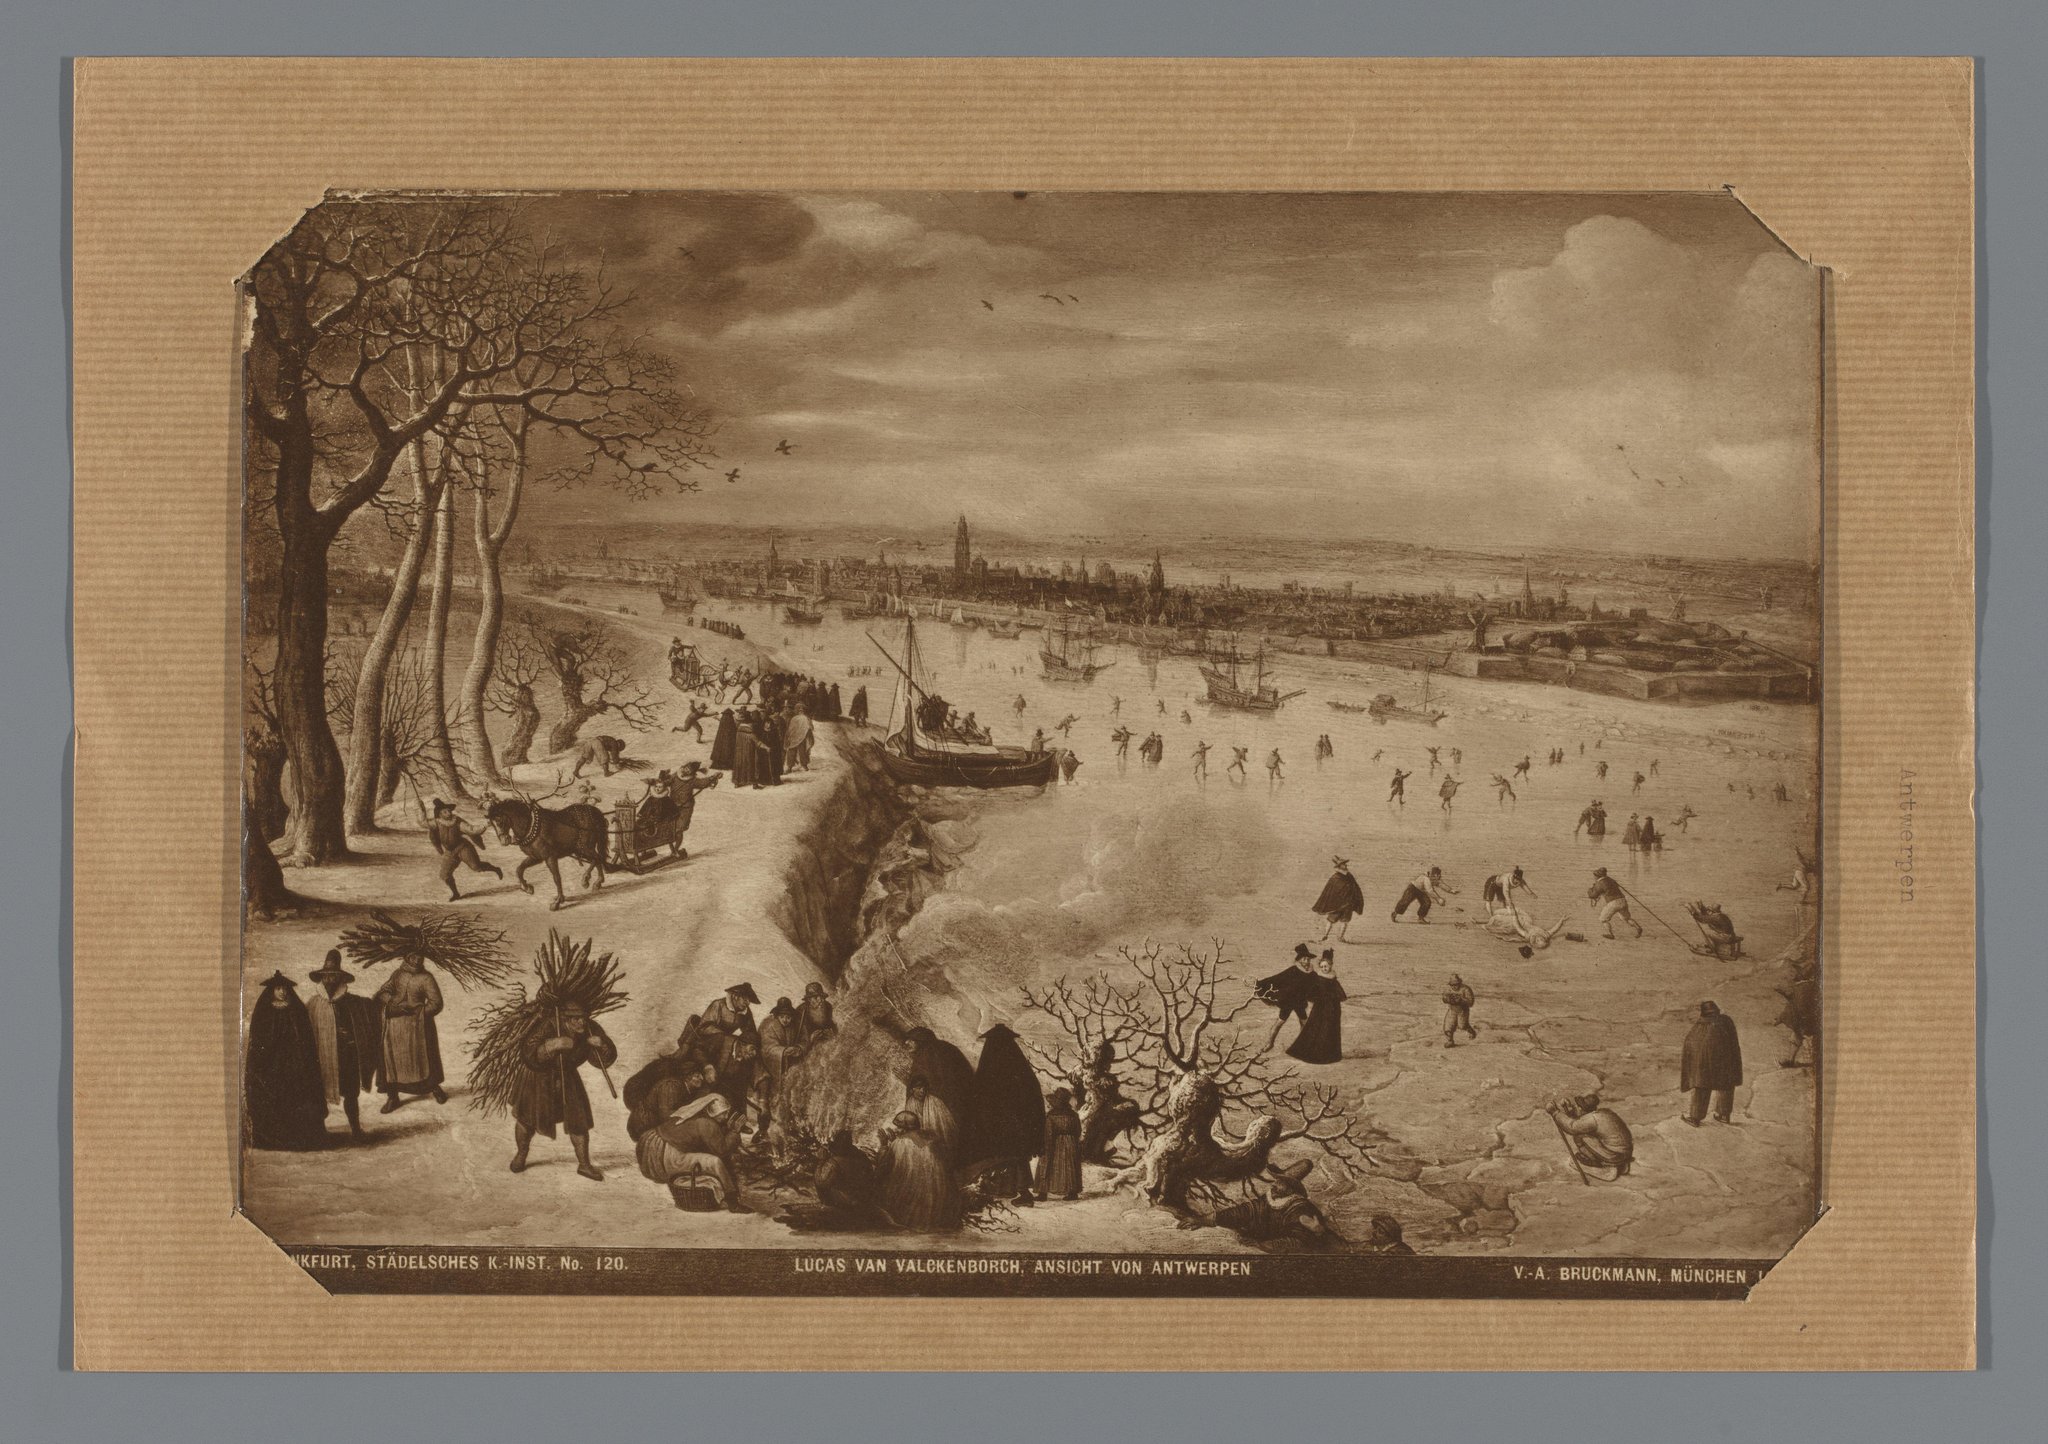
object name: photograph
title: Antwerpen. Lucas van Valckenborch. Ansicht von Antwerpen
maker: Anonymous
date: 1850-1900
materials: photographic support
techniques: albumen print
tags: antwerp